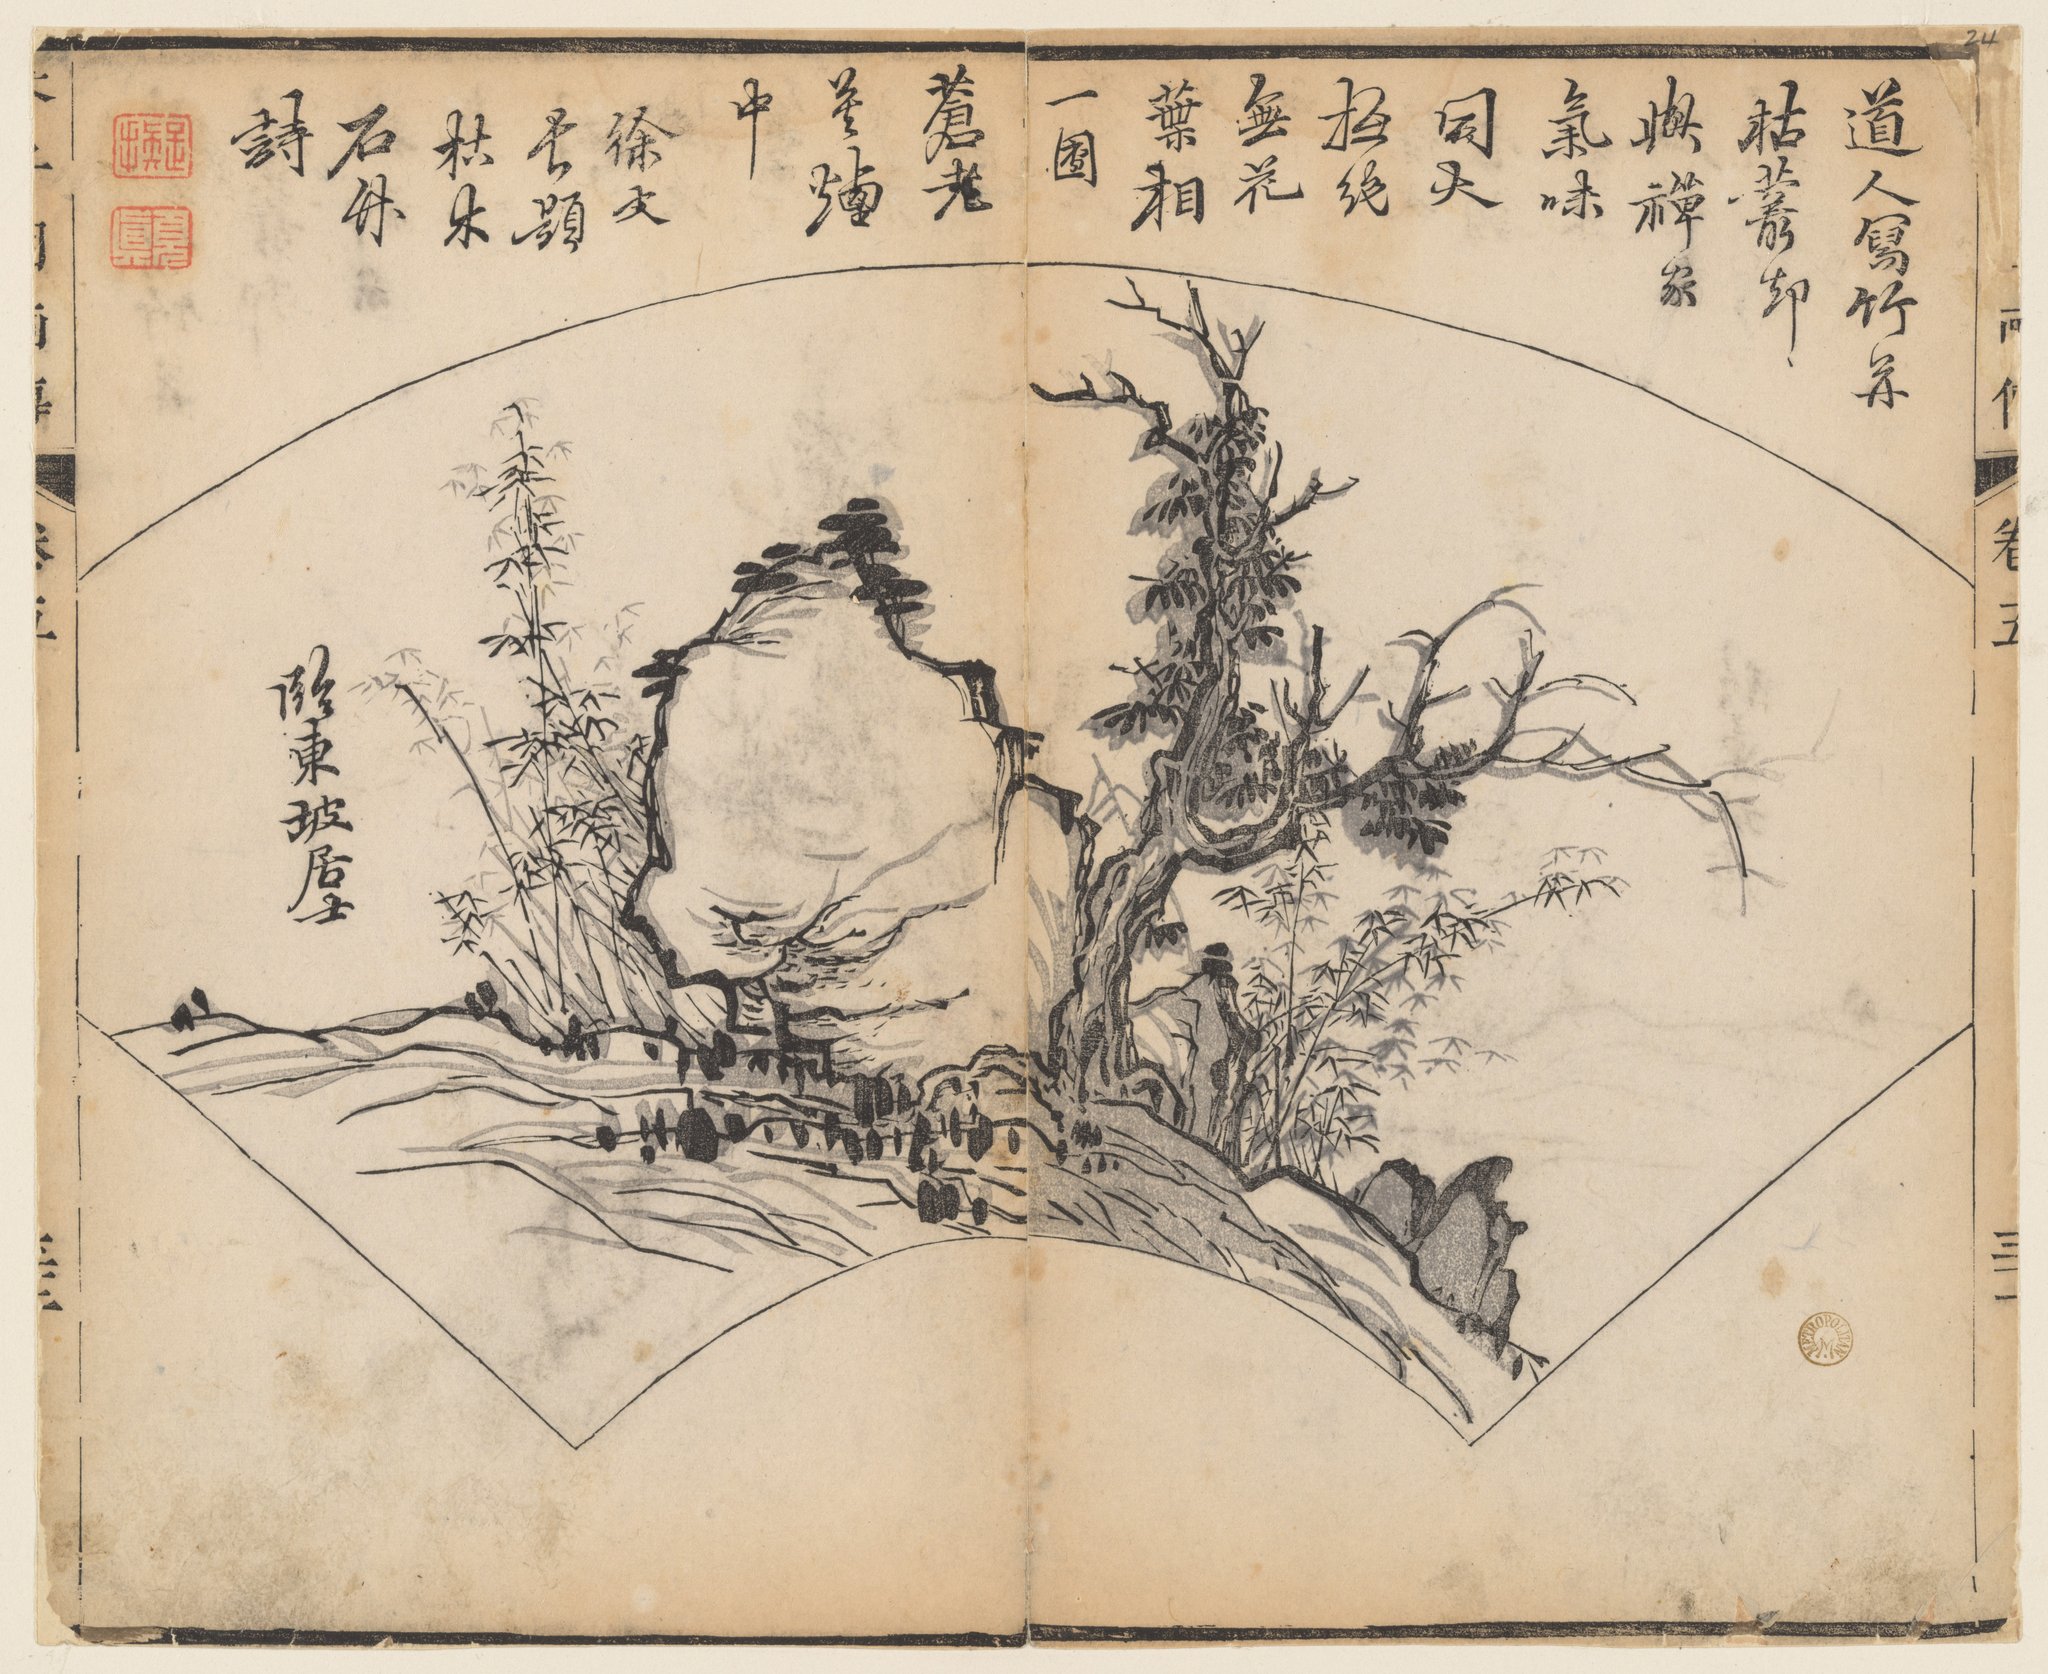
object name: print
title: Page from the Mustard Seed Garden Manual of Painting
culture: chinese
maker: wang gai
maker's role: artist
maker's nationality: chinese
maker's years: 1645-1710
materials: ink, paper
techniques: woodblock print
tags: trees